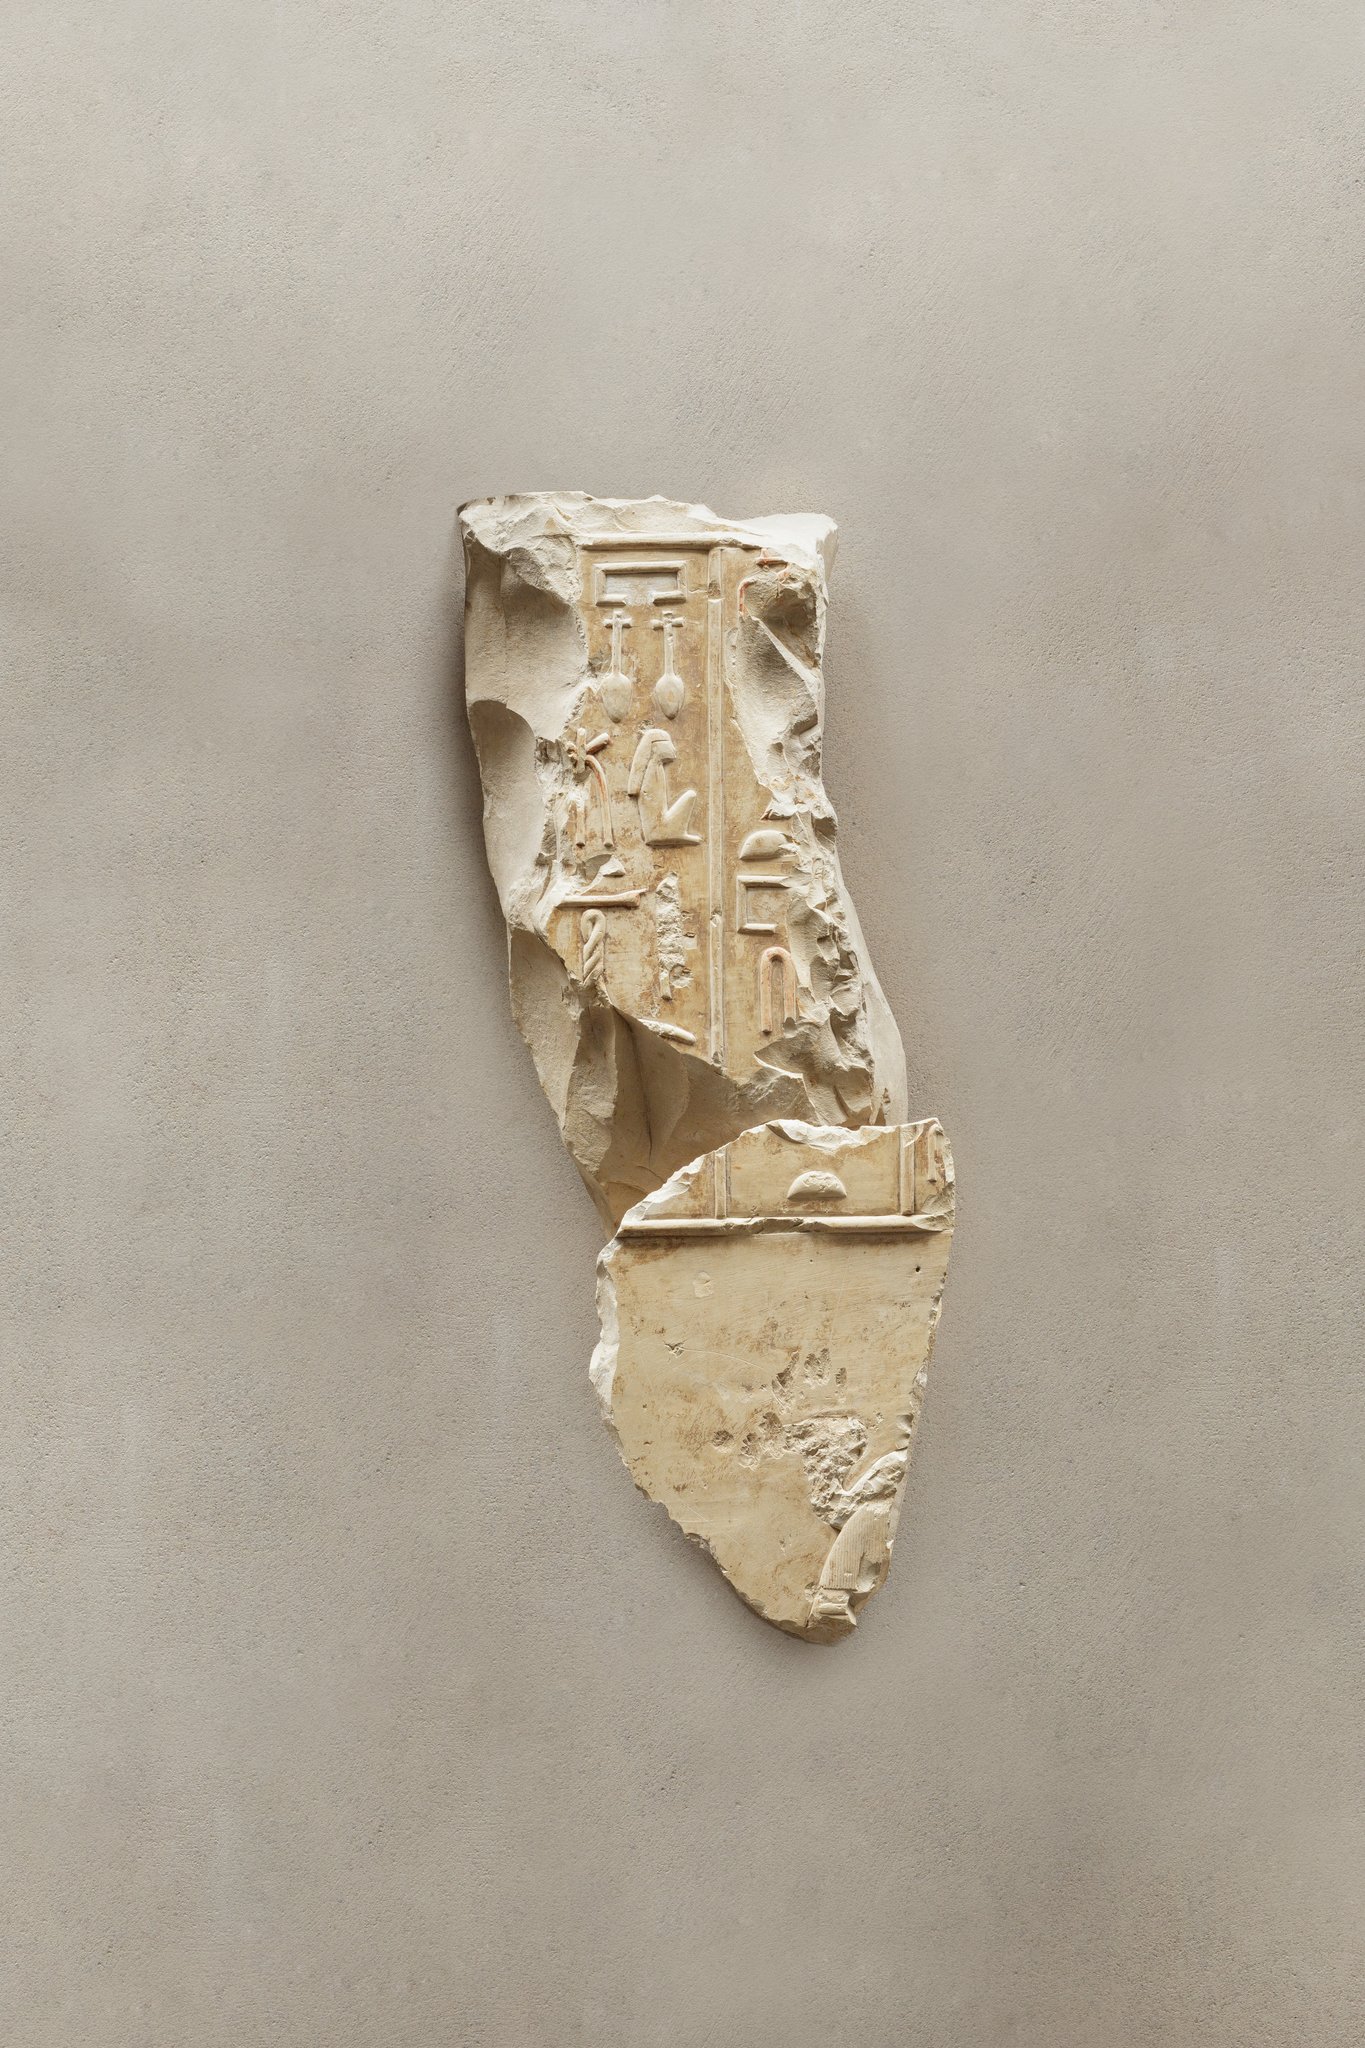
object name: relief, part of scene with king and queen, neferu, graffito, graffiti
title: Relief preserving part of a scene with the king and queen - see 26.3.353-4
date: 2051-2030 BCE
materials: limestone, paint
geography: egypt